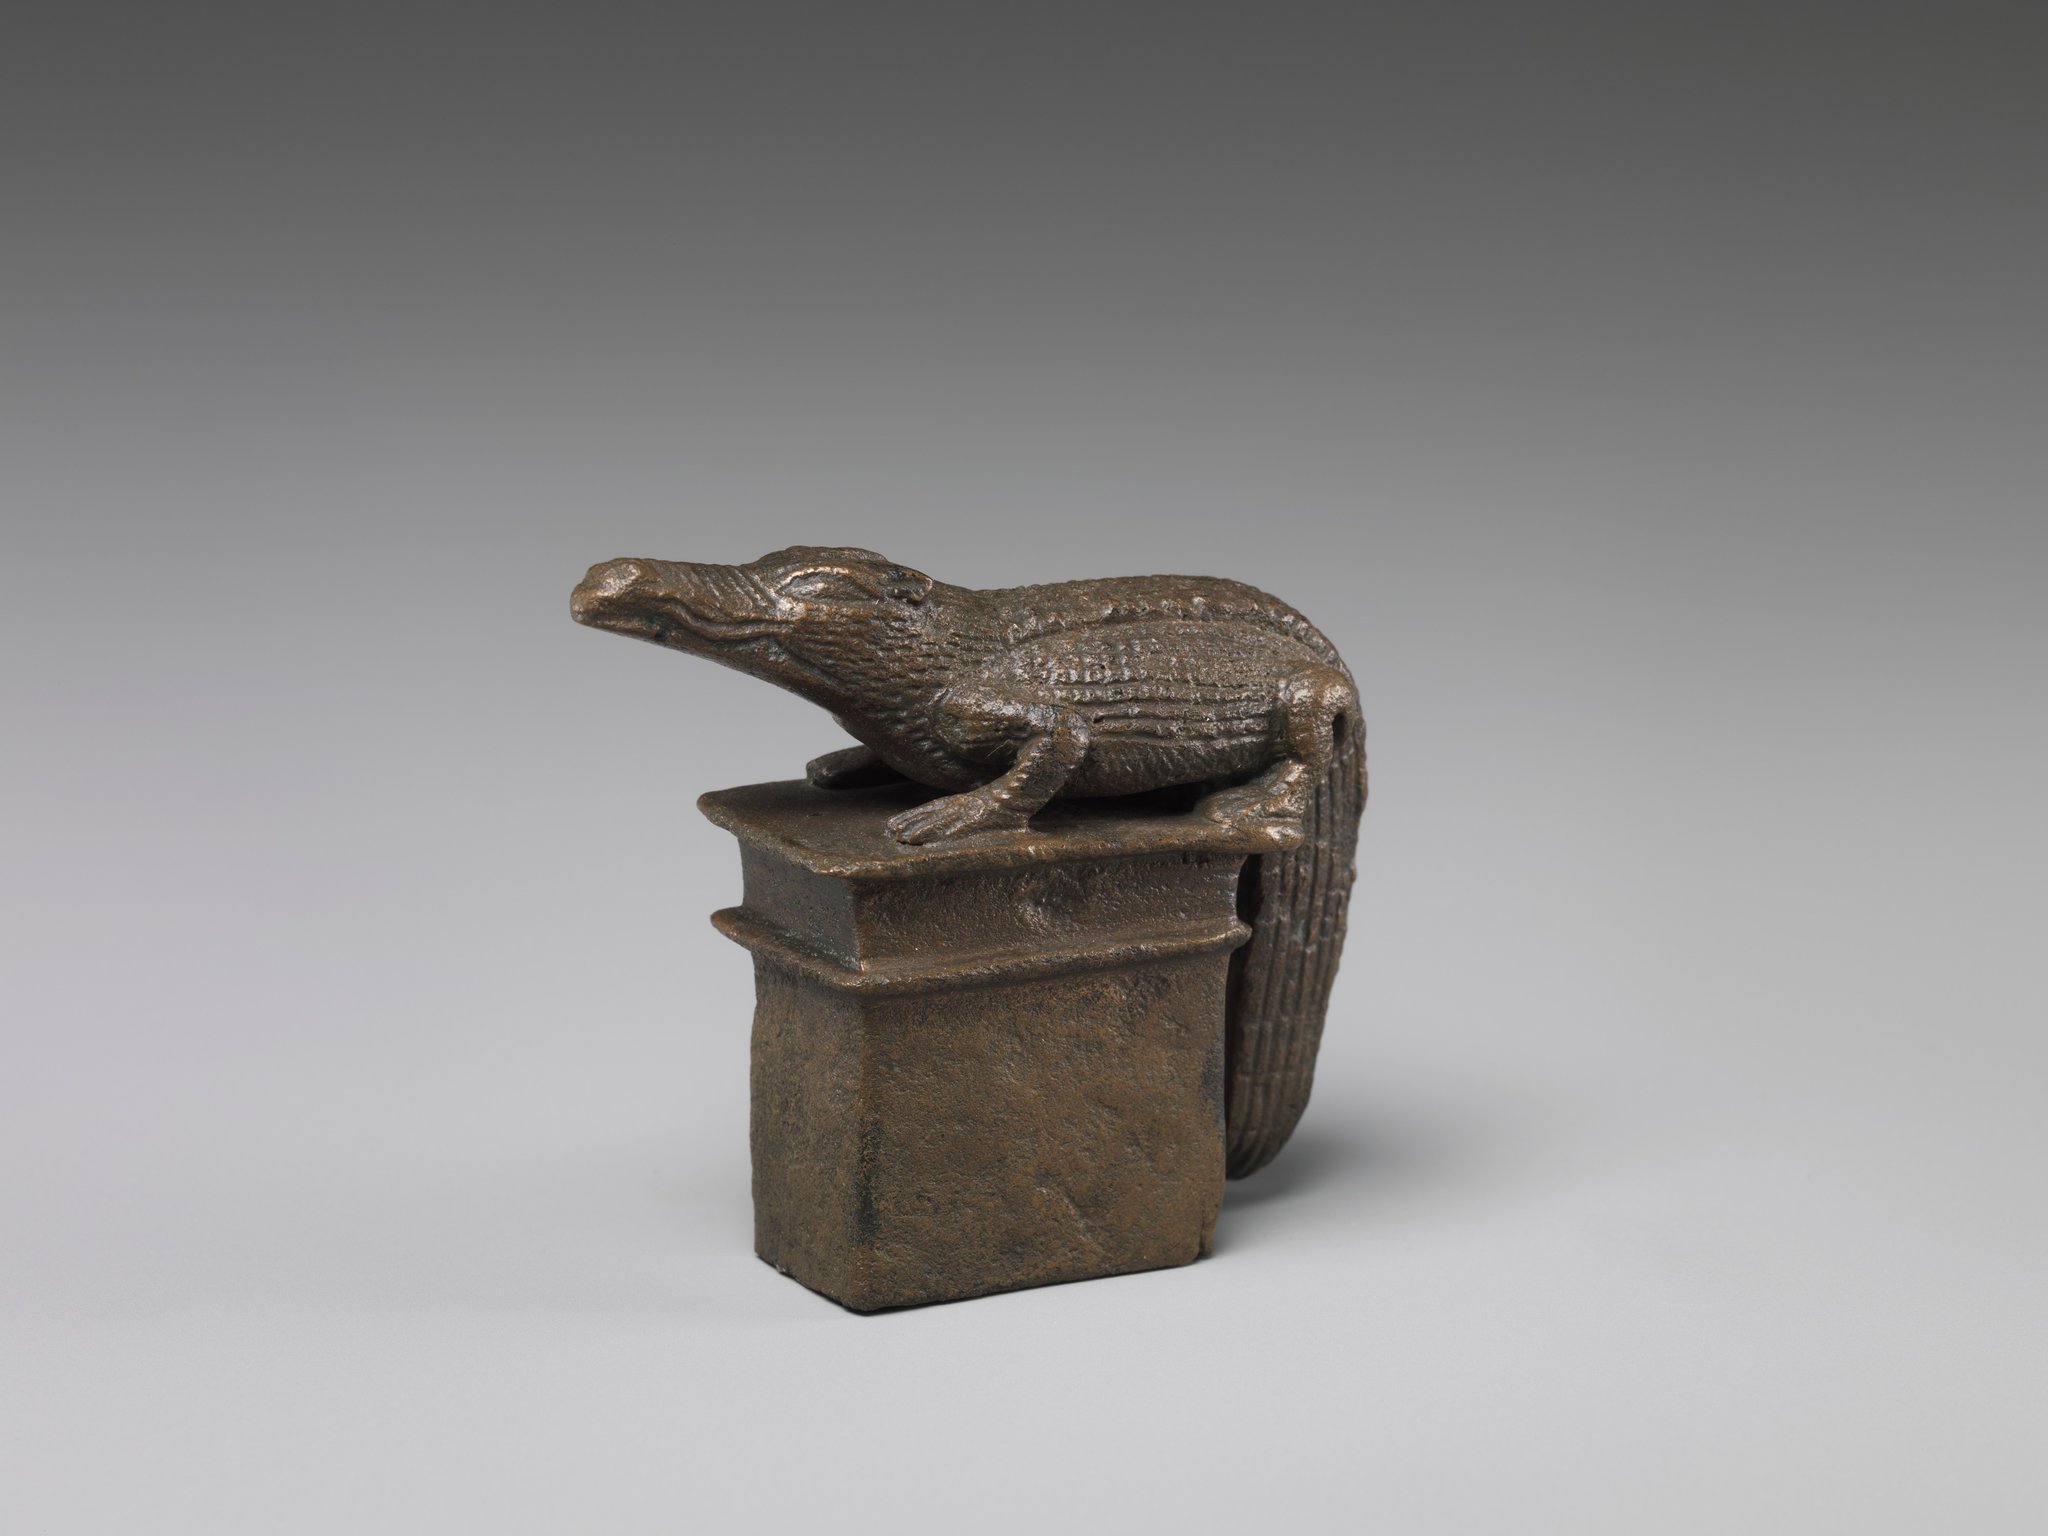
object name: crocodile, shrine shaped base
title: Crocodile on a shrine-shaped base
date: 332-330 BCE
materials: metal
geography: egypt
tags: crocodiles